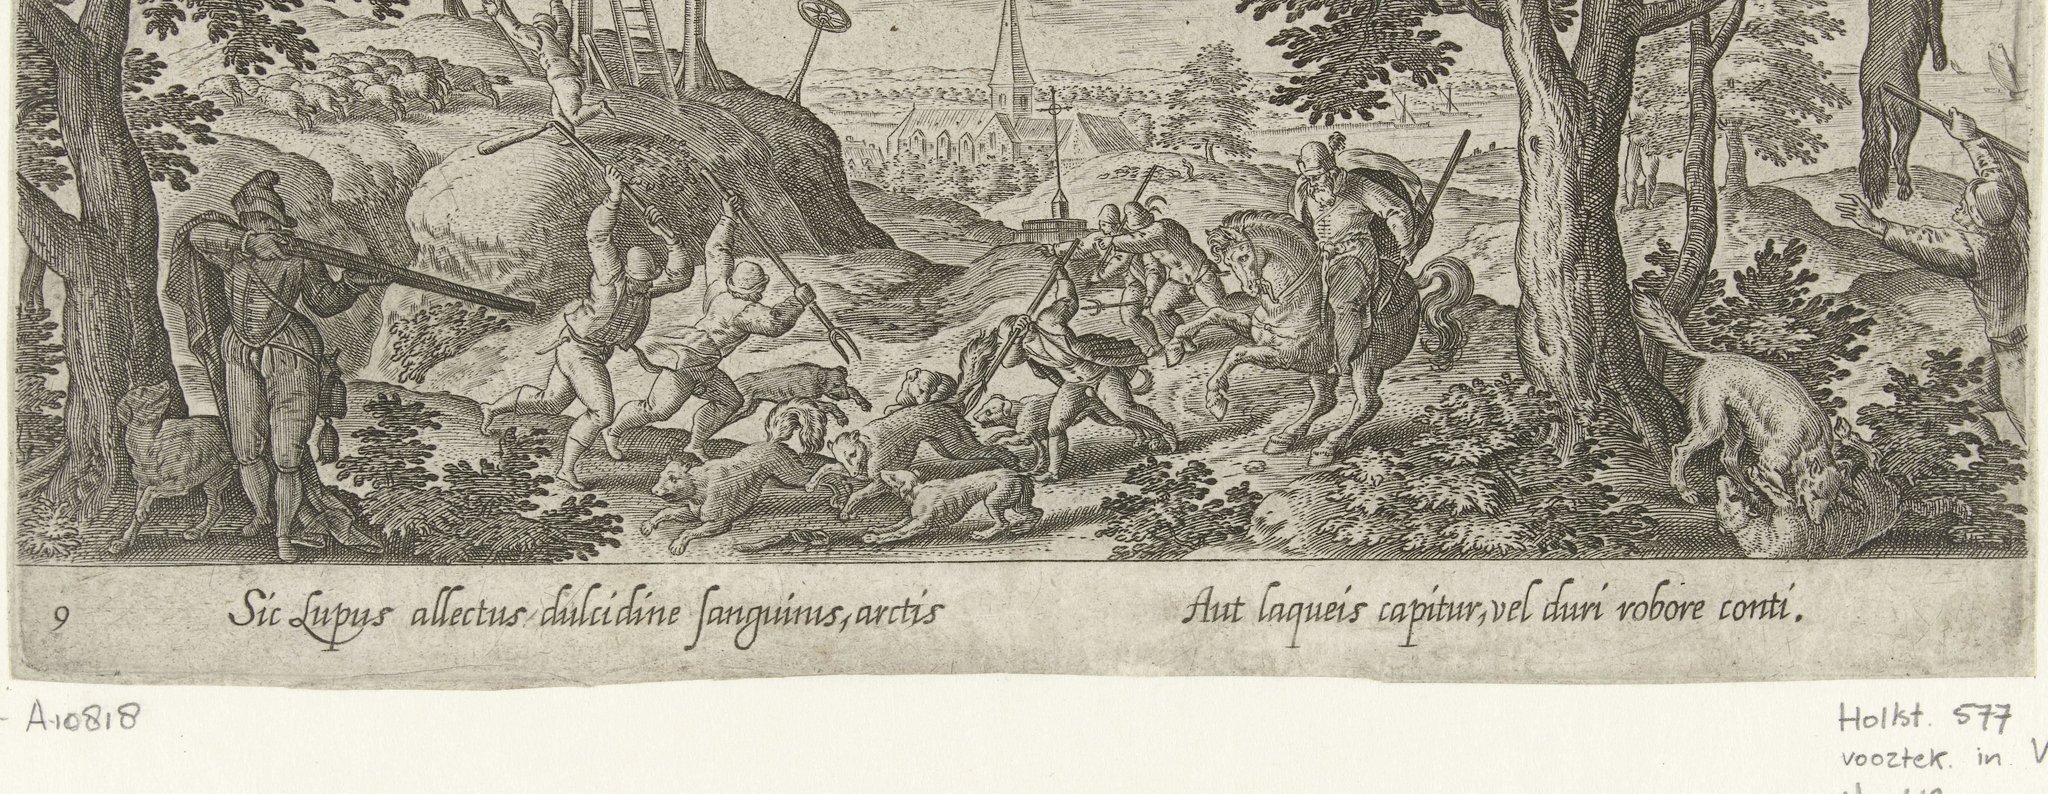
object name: print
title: Venationes, Piscationes et Aucupii Typi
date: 1582-1633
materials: paper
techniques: engraving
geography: antwerp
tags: hunt ~ predatory animals (fox, lion) (+ hunting with dogs), beasts of prey, predatory animals: wolf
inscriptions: collector's mark: Lugt 2228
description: Jachthonden jagen wolven op die vervolgens door jagers worden gedood met speren en stokken. De prent heeft een Latijns onderschrift en maakt deel uit van een serie van 54 prenten.